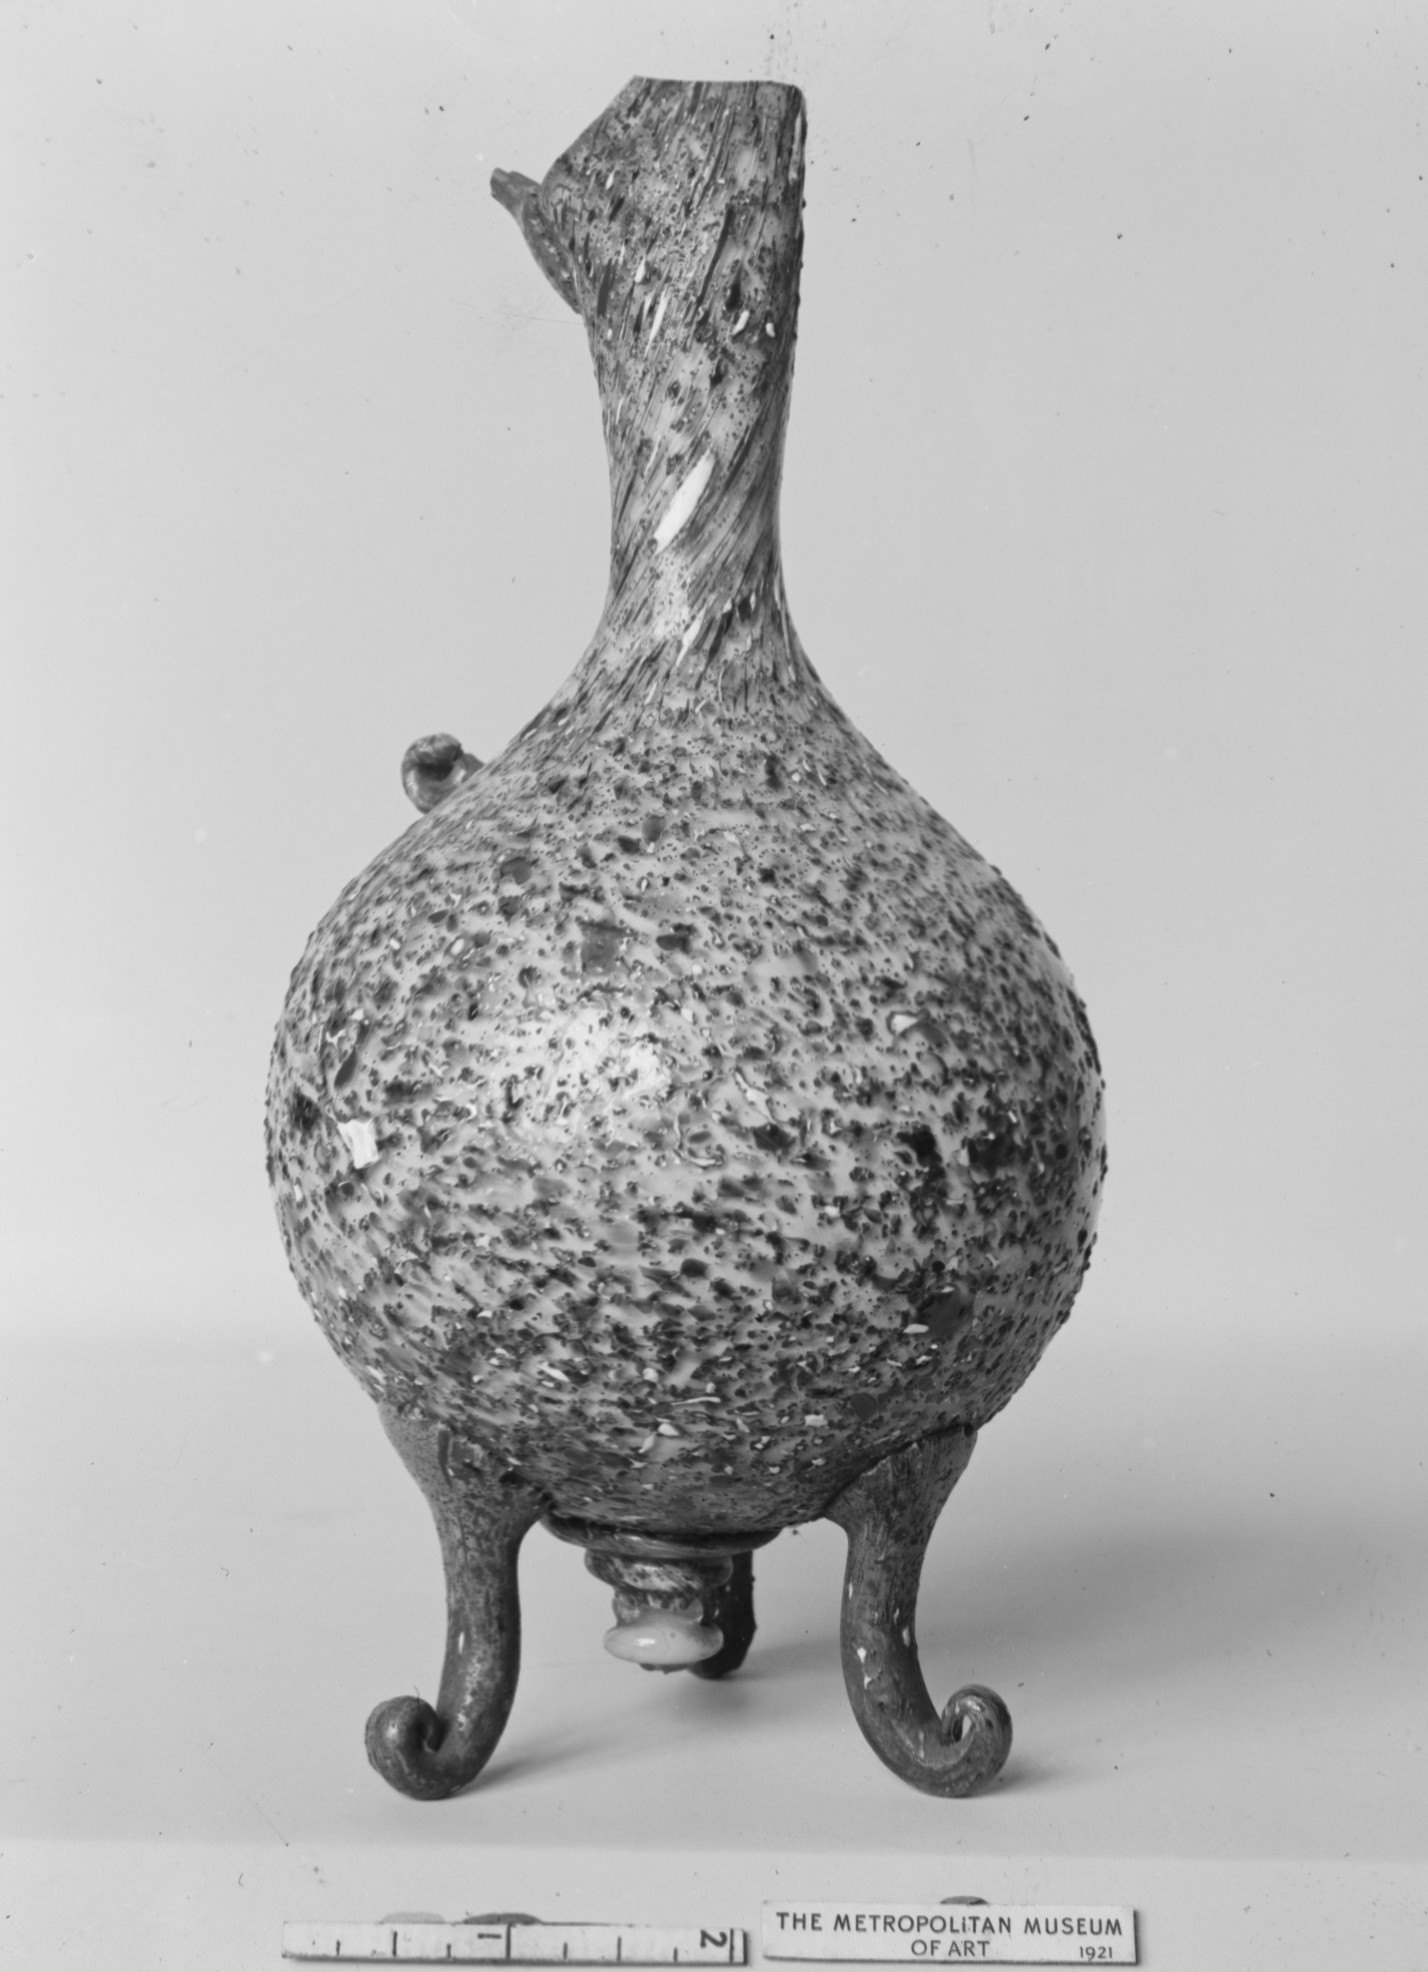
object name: ewer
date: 1801-1900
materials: glass